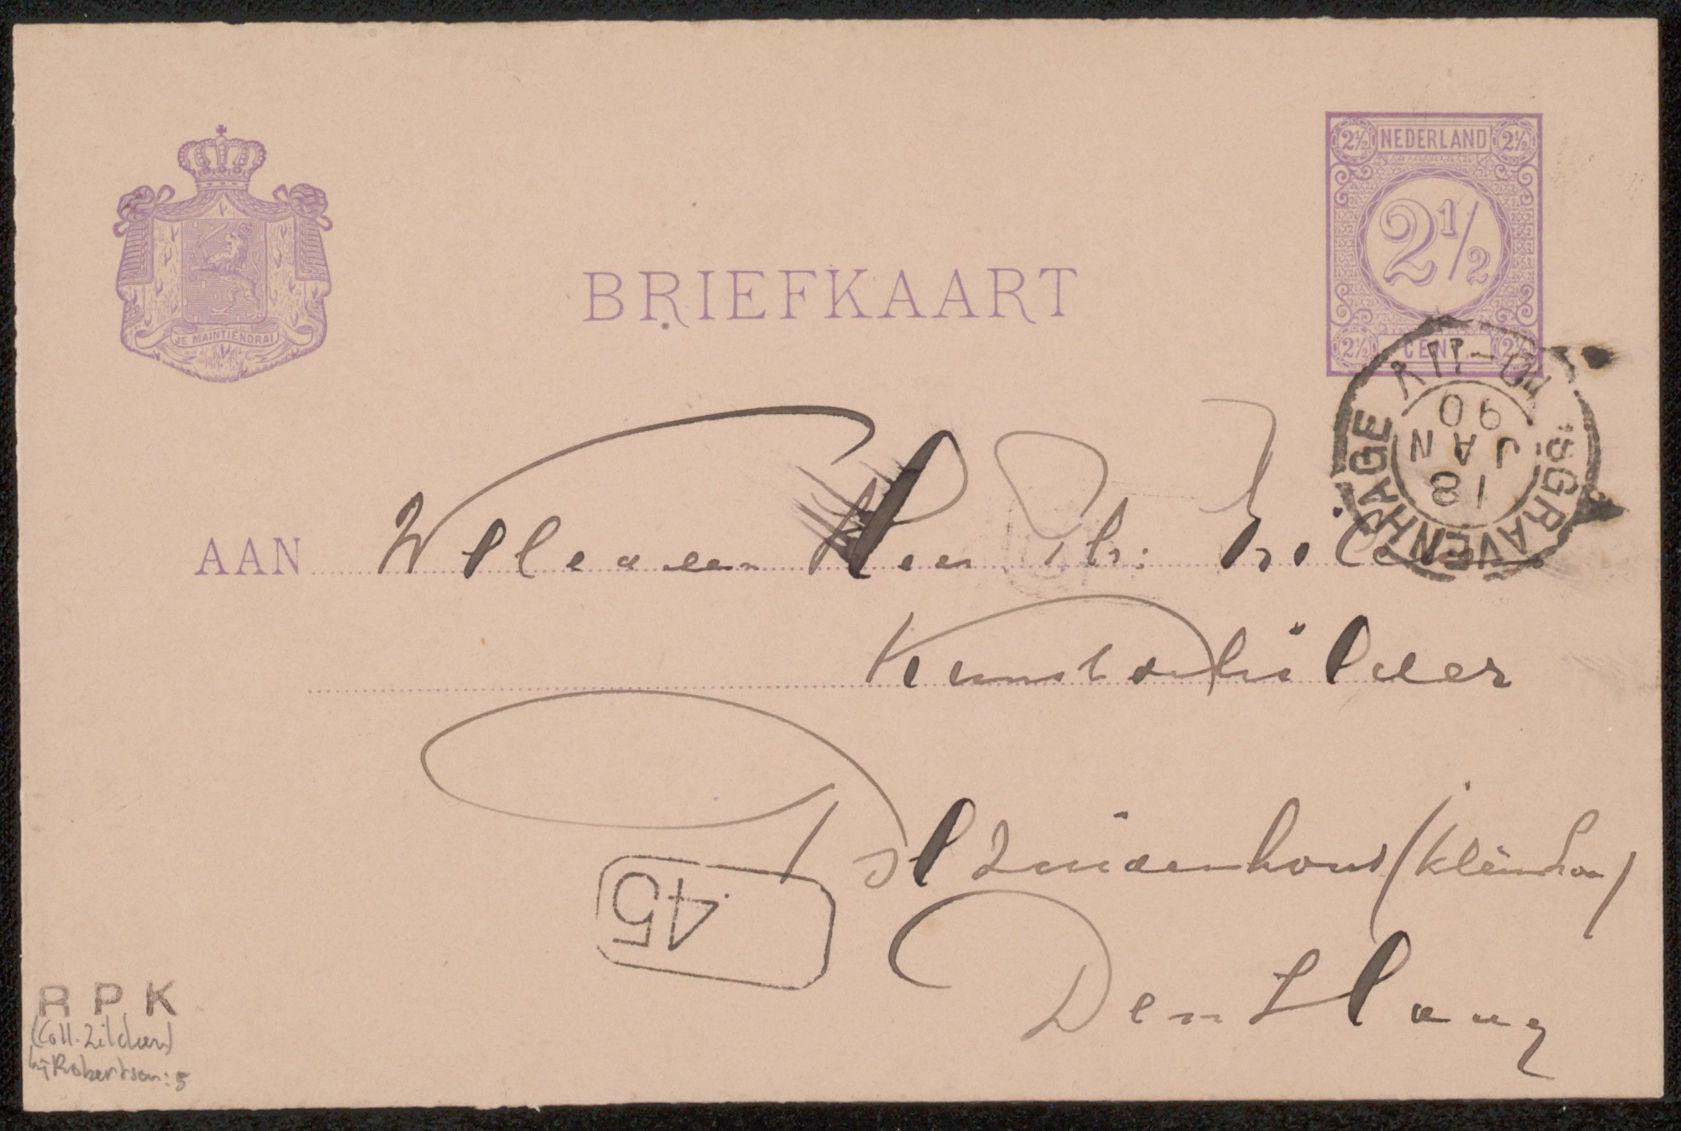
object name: postcard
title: Briefkaart aan Philip Zilcken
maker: suze robertson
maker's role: draughtsman, painter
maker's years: 1855-1922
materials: cardboard, ink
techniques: pen, writing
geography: the hague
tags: print maker, cornelia van der hart, painter, draughtsman, philip zilcken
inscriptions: collector's mark: ‘RPK’